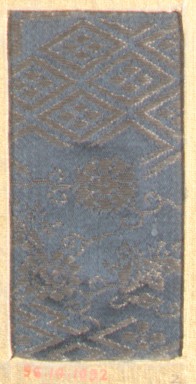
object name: piece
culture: japanese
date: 1701-1900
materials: silk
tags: flowers